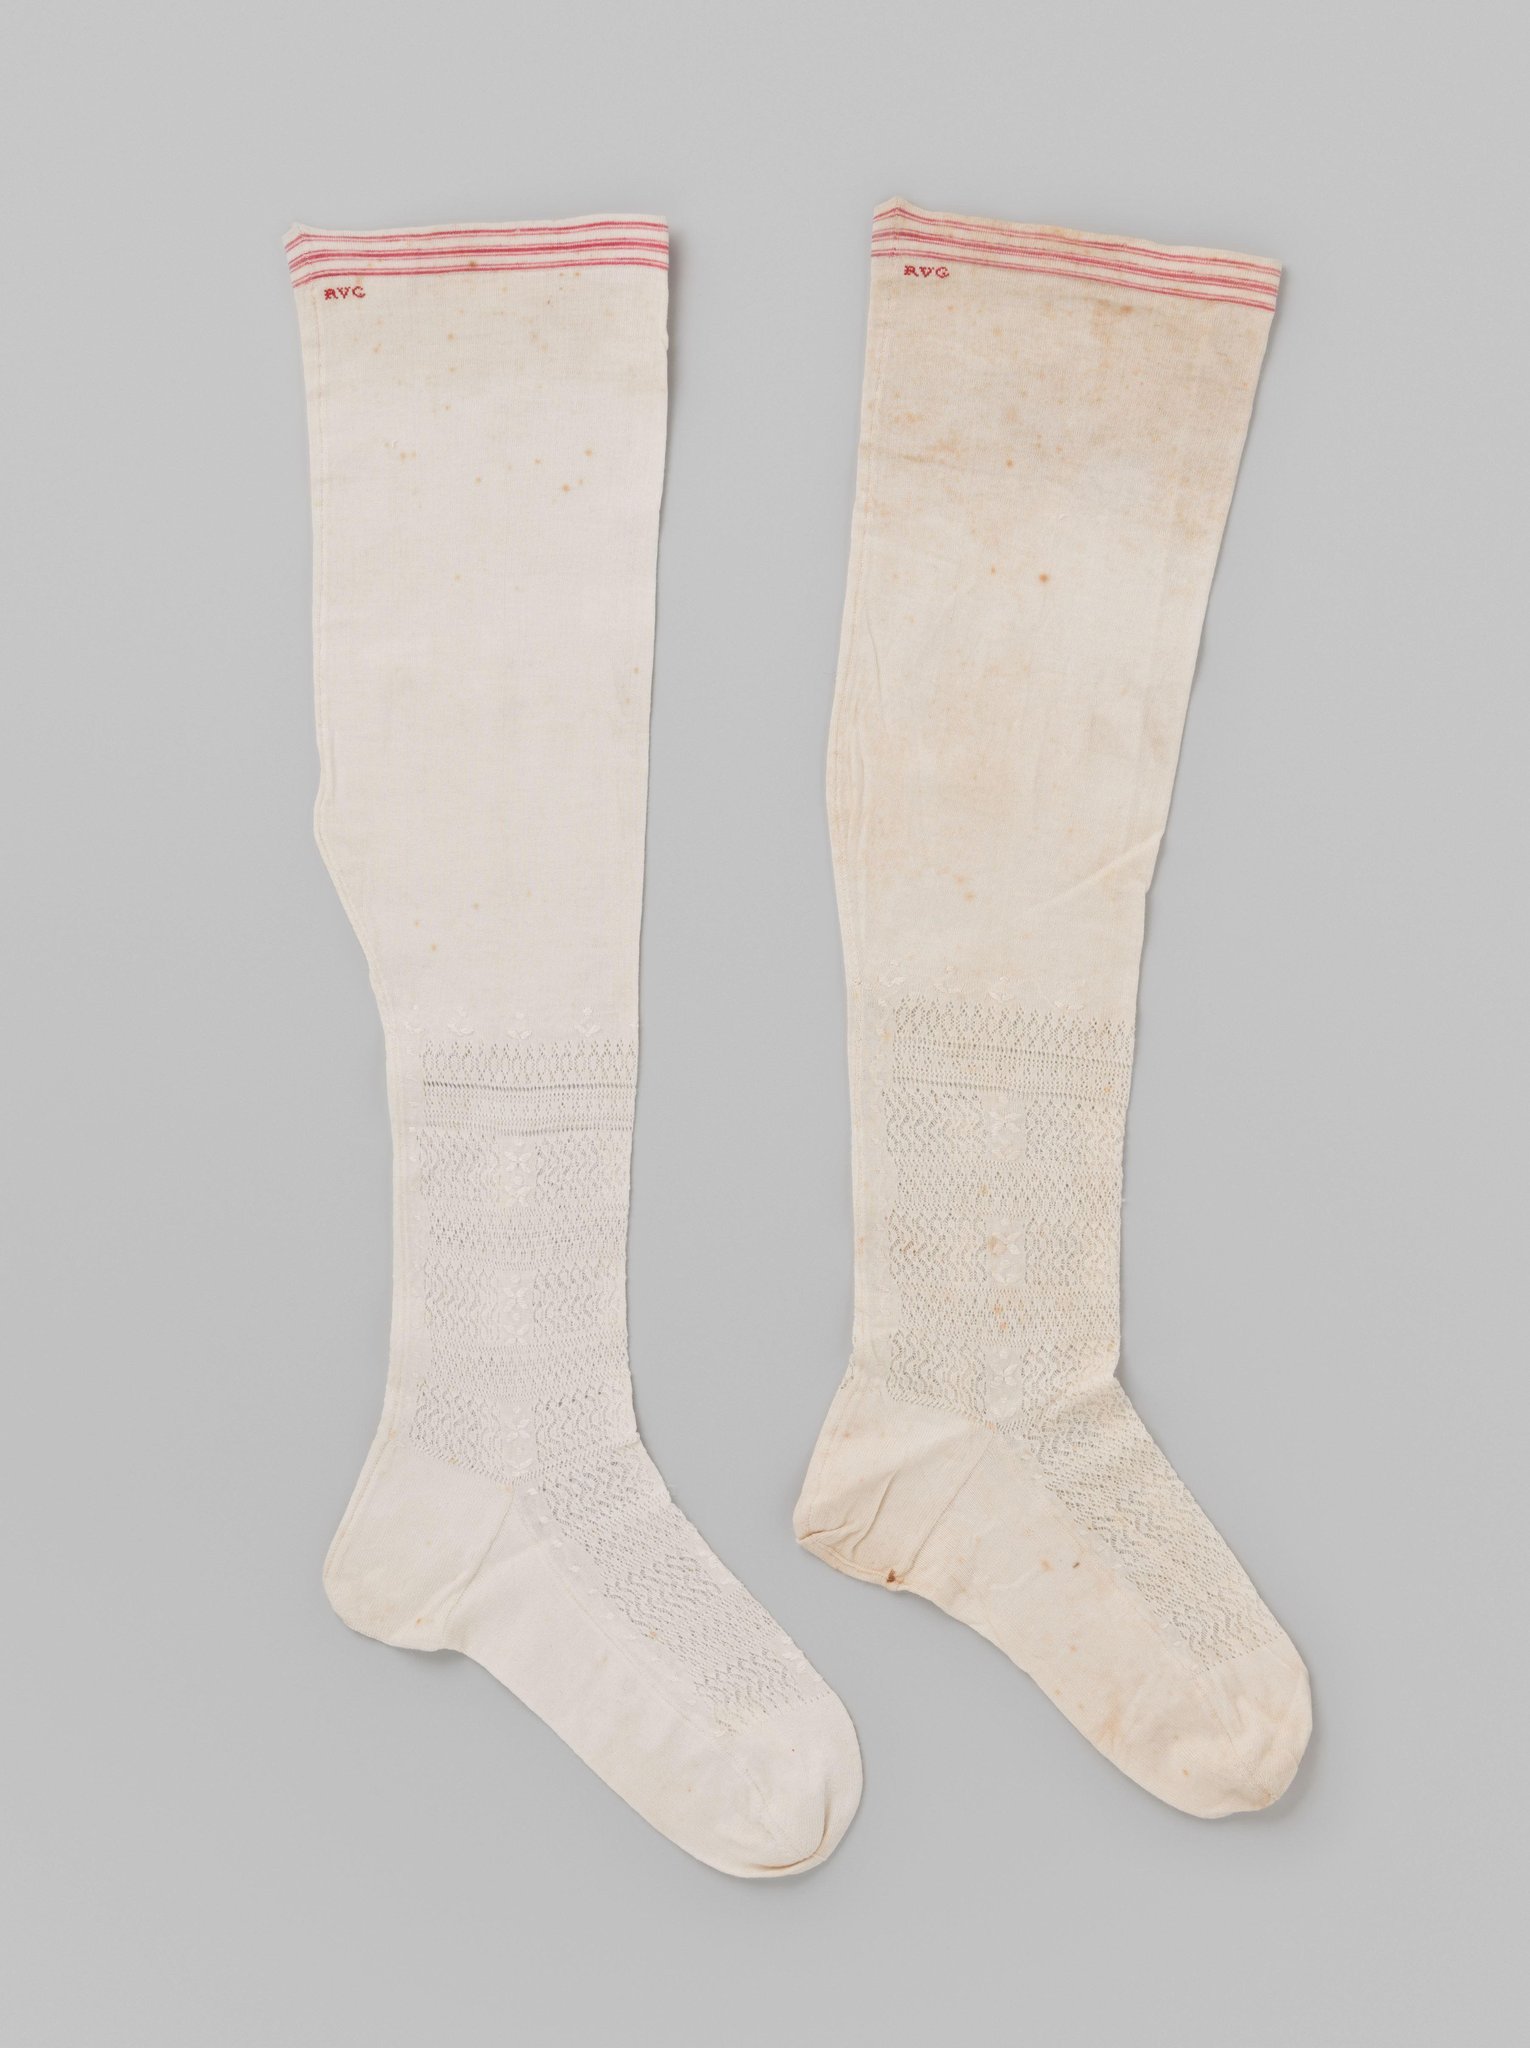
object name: stocking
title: Kous van wit gebreid katoen, ajour fantasiepatroon op klink en wreef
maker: Anonymous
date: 1850-1900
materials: cotton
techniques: embroidered, knitting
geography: netherlands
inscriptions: initials: ‘RVG’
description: Paar kousen van wit gebreid katoen. Fantasiepatroon op been en wreef. Met naad en vierkante hiel. Aan de boord enkele smalle, ronde banden. Onder de boord rechts van de naad met rode kruissteekjes gemerkt: RVG. Afkomstig uit de familie van Geuns te Amsterdam: Rebekka Anna van Geuns (1839-1909) of Regina Christina van Geuns (1848- ).